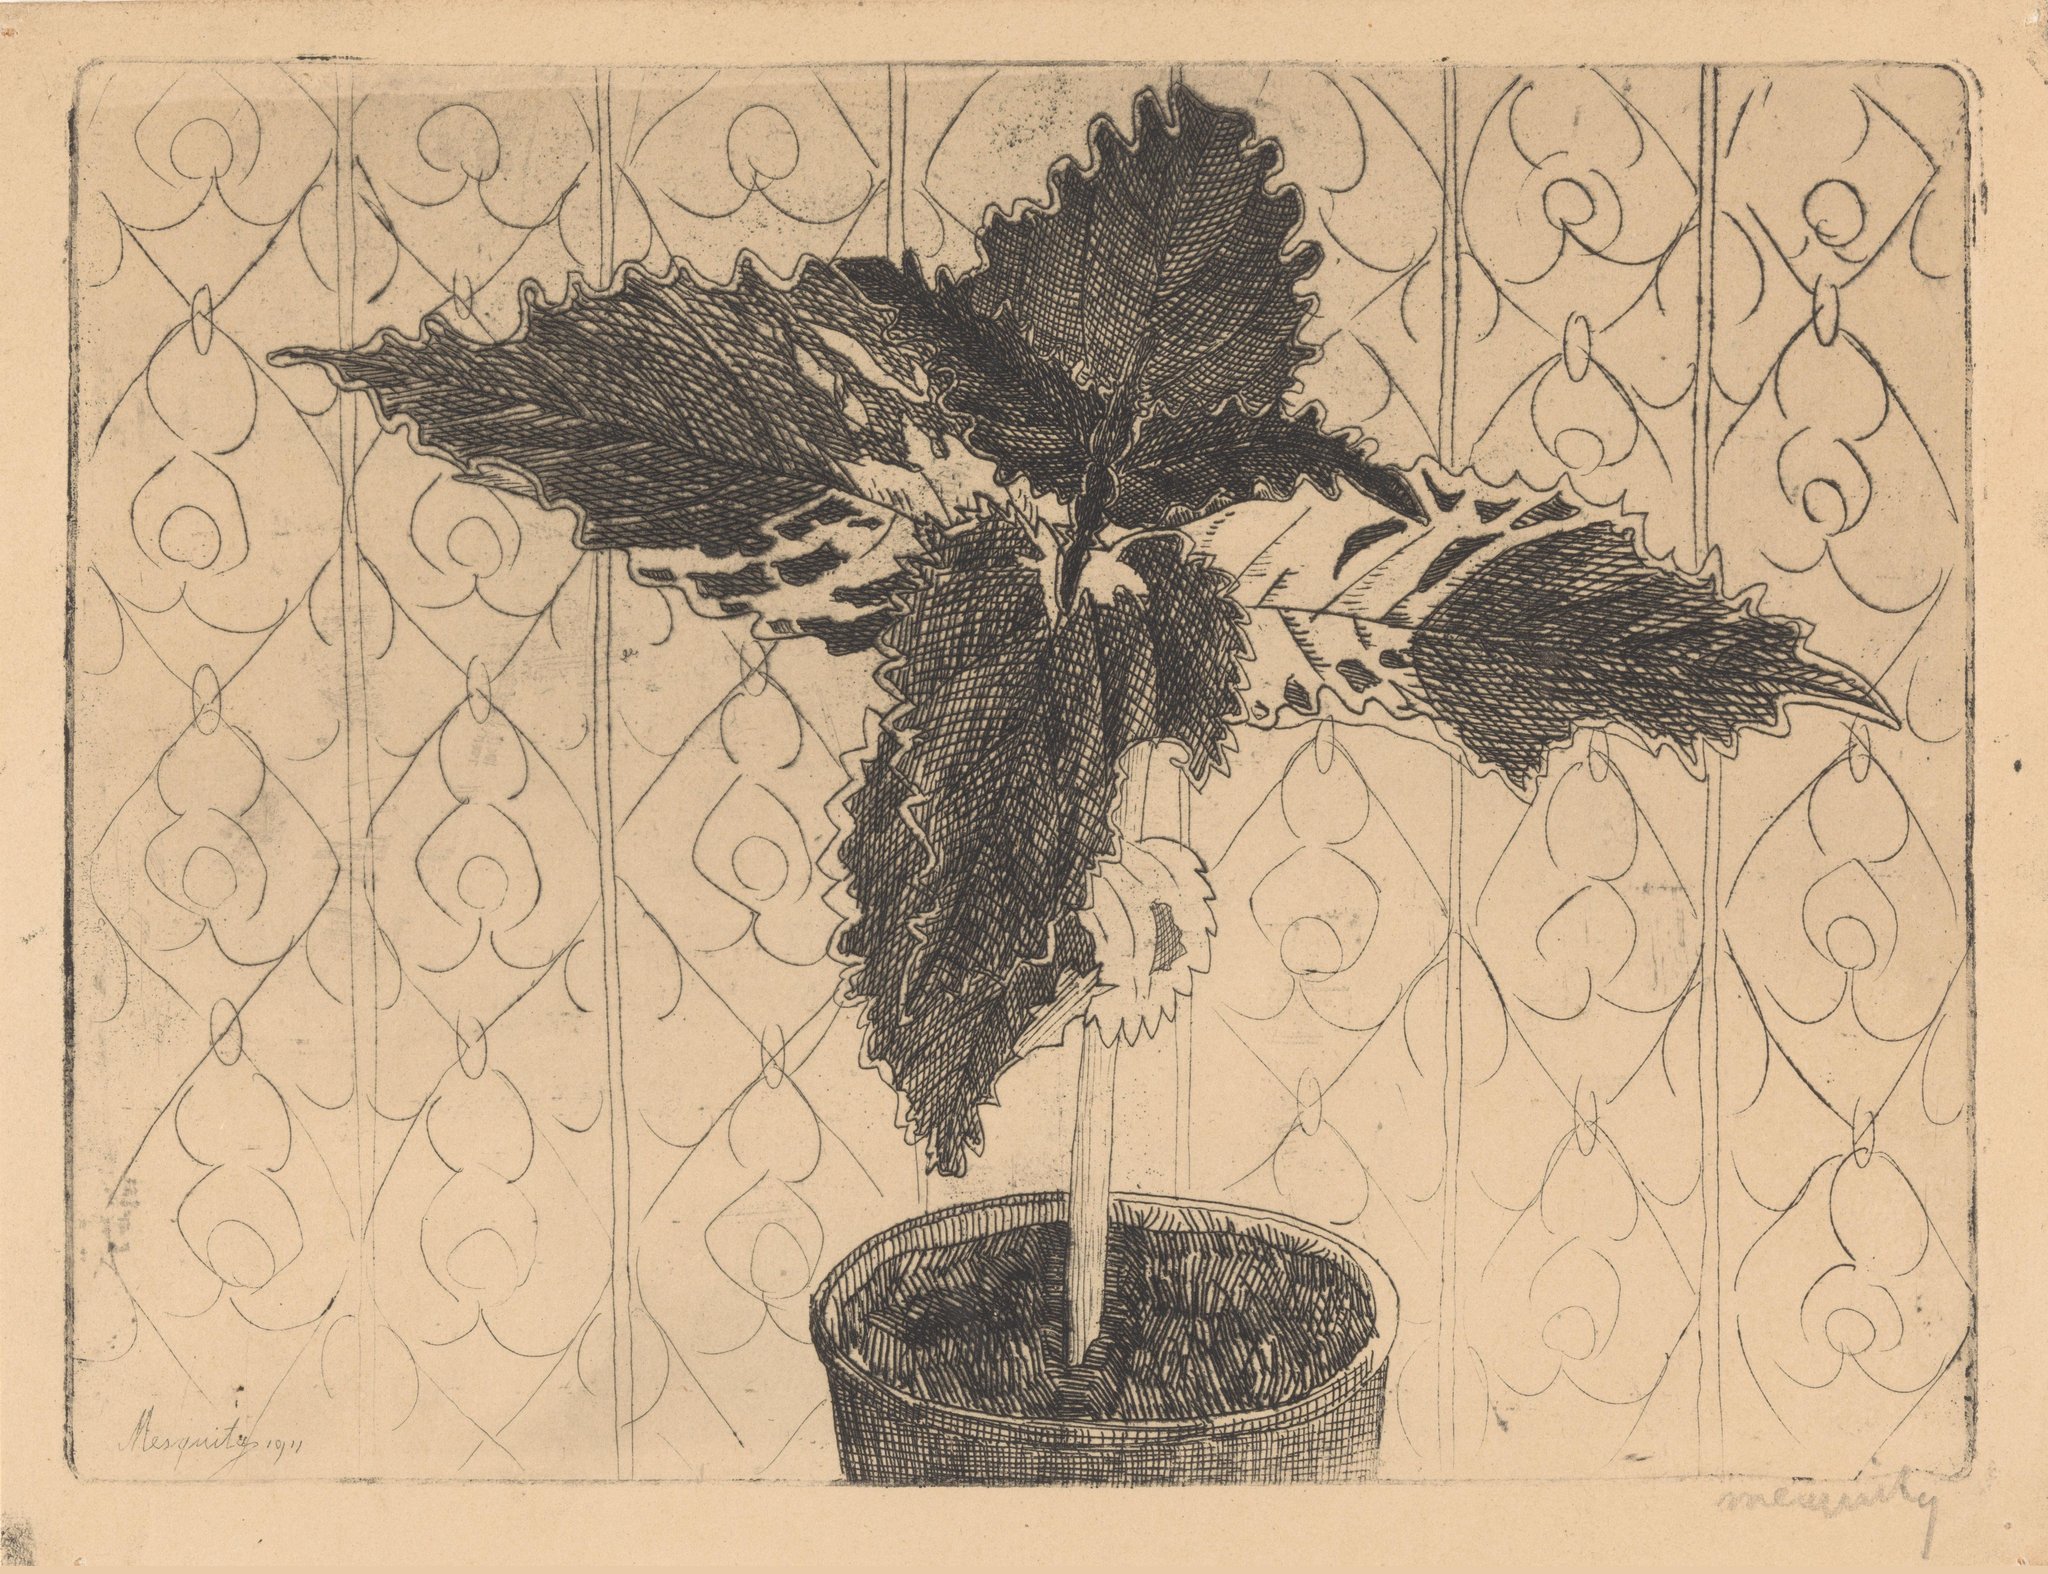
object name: print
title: Sierbrandnetel in pot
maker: samuel jessurun de mesquita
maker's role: draughtsman, print maker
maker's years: 1868-1944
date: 1911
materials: paper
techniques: etching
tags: potted plants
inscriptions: collector's mark: Lugt 2228